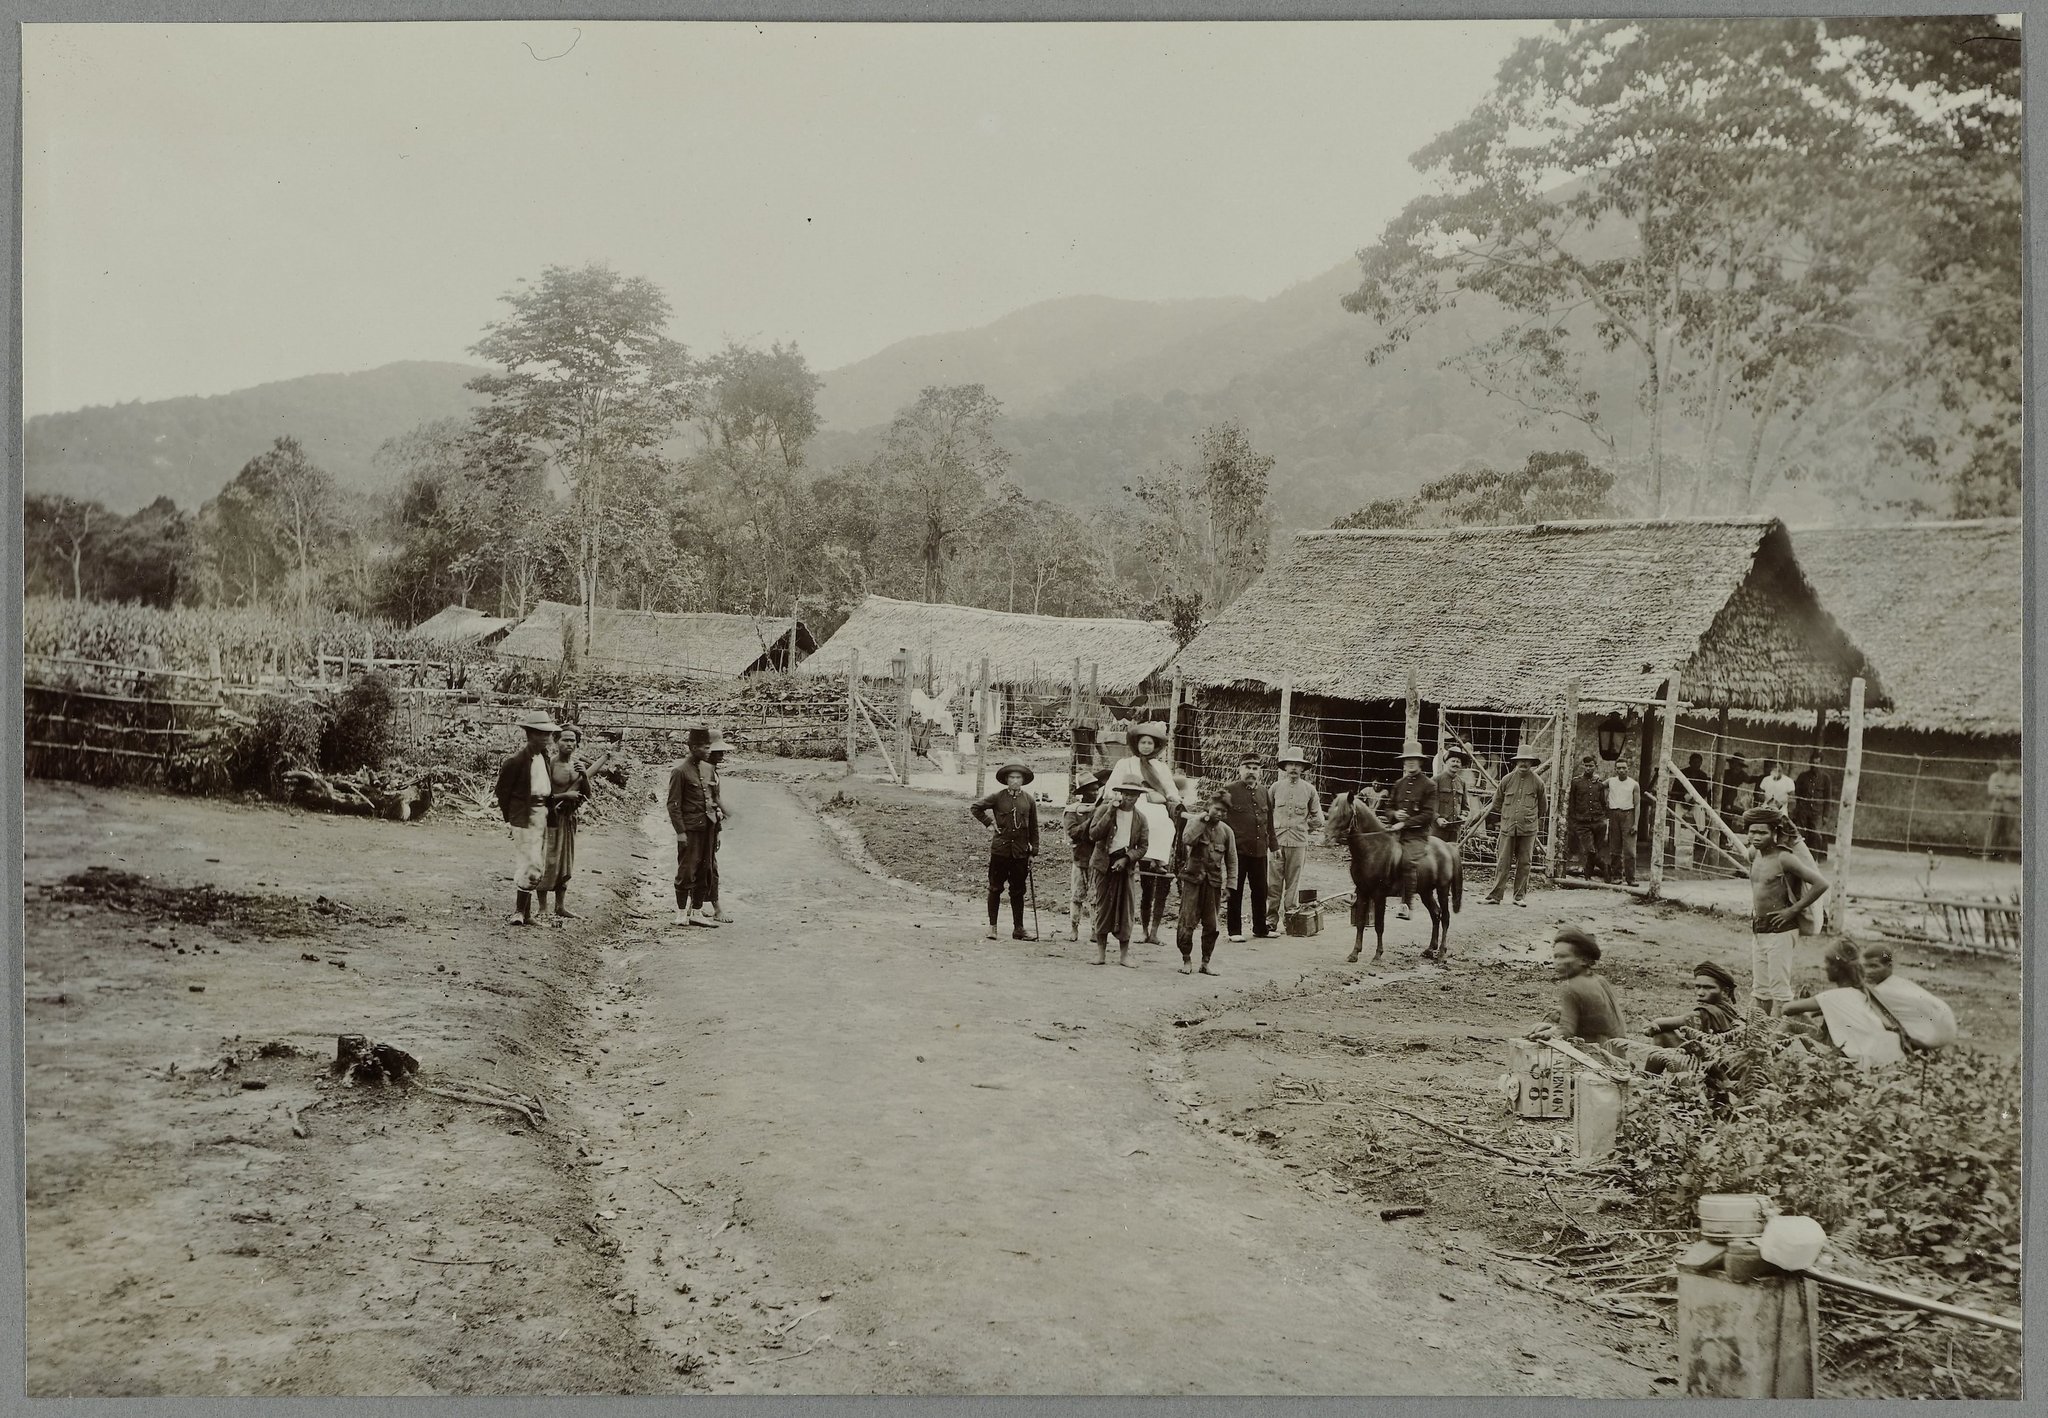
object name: photograph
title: Bivak bij de Boer ni Poepandji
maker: Anonymous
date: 1903-1913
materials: photographic support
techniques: photography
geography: north sumatra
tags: arnhem, albertus dominicus laman trip, landscapes in tropical and sub-tropical regions, village, road, path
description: Na de expedities naar de Gajo- en Alaslanden o.l.v. Van Daalen (eerste tocht in 1901), werd hij in 1903 belast met voorbereiding van permanente vestiging van Nederlands gezag. Aanleg van een weg van de Noordkust naar het binnenland was hierbij van groot belang. Deze zgn. Gajoweg werd aangelegd tussen 1903 en 1914, van Bireuen aan de kust naar Takinguen aan het bergmeer Danau Lauttawar, totale lente 104 km.